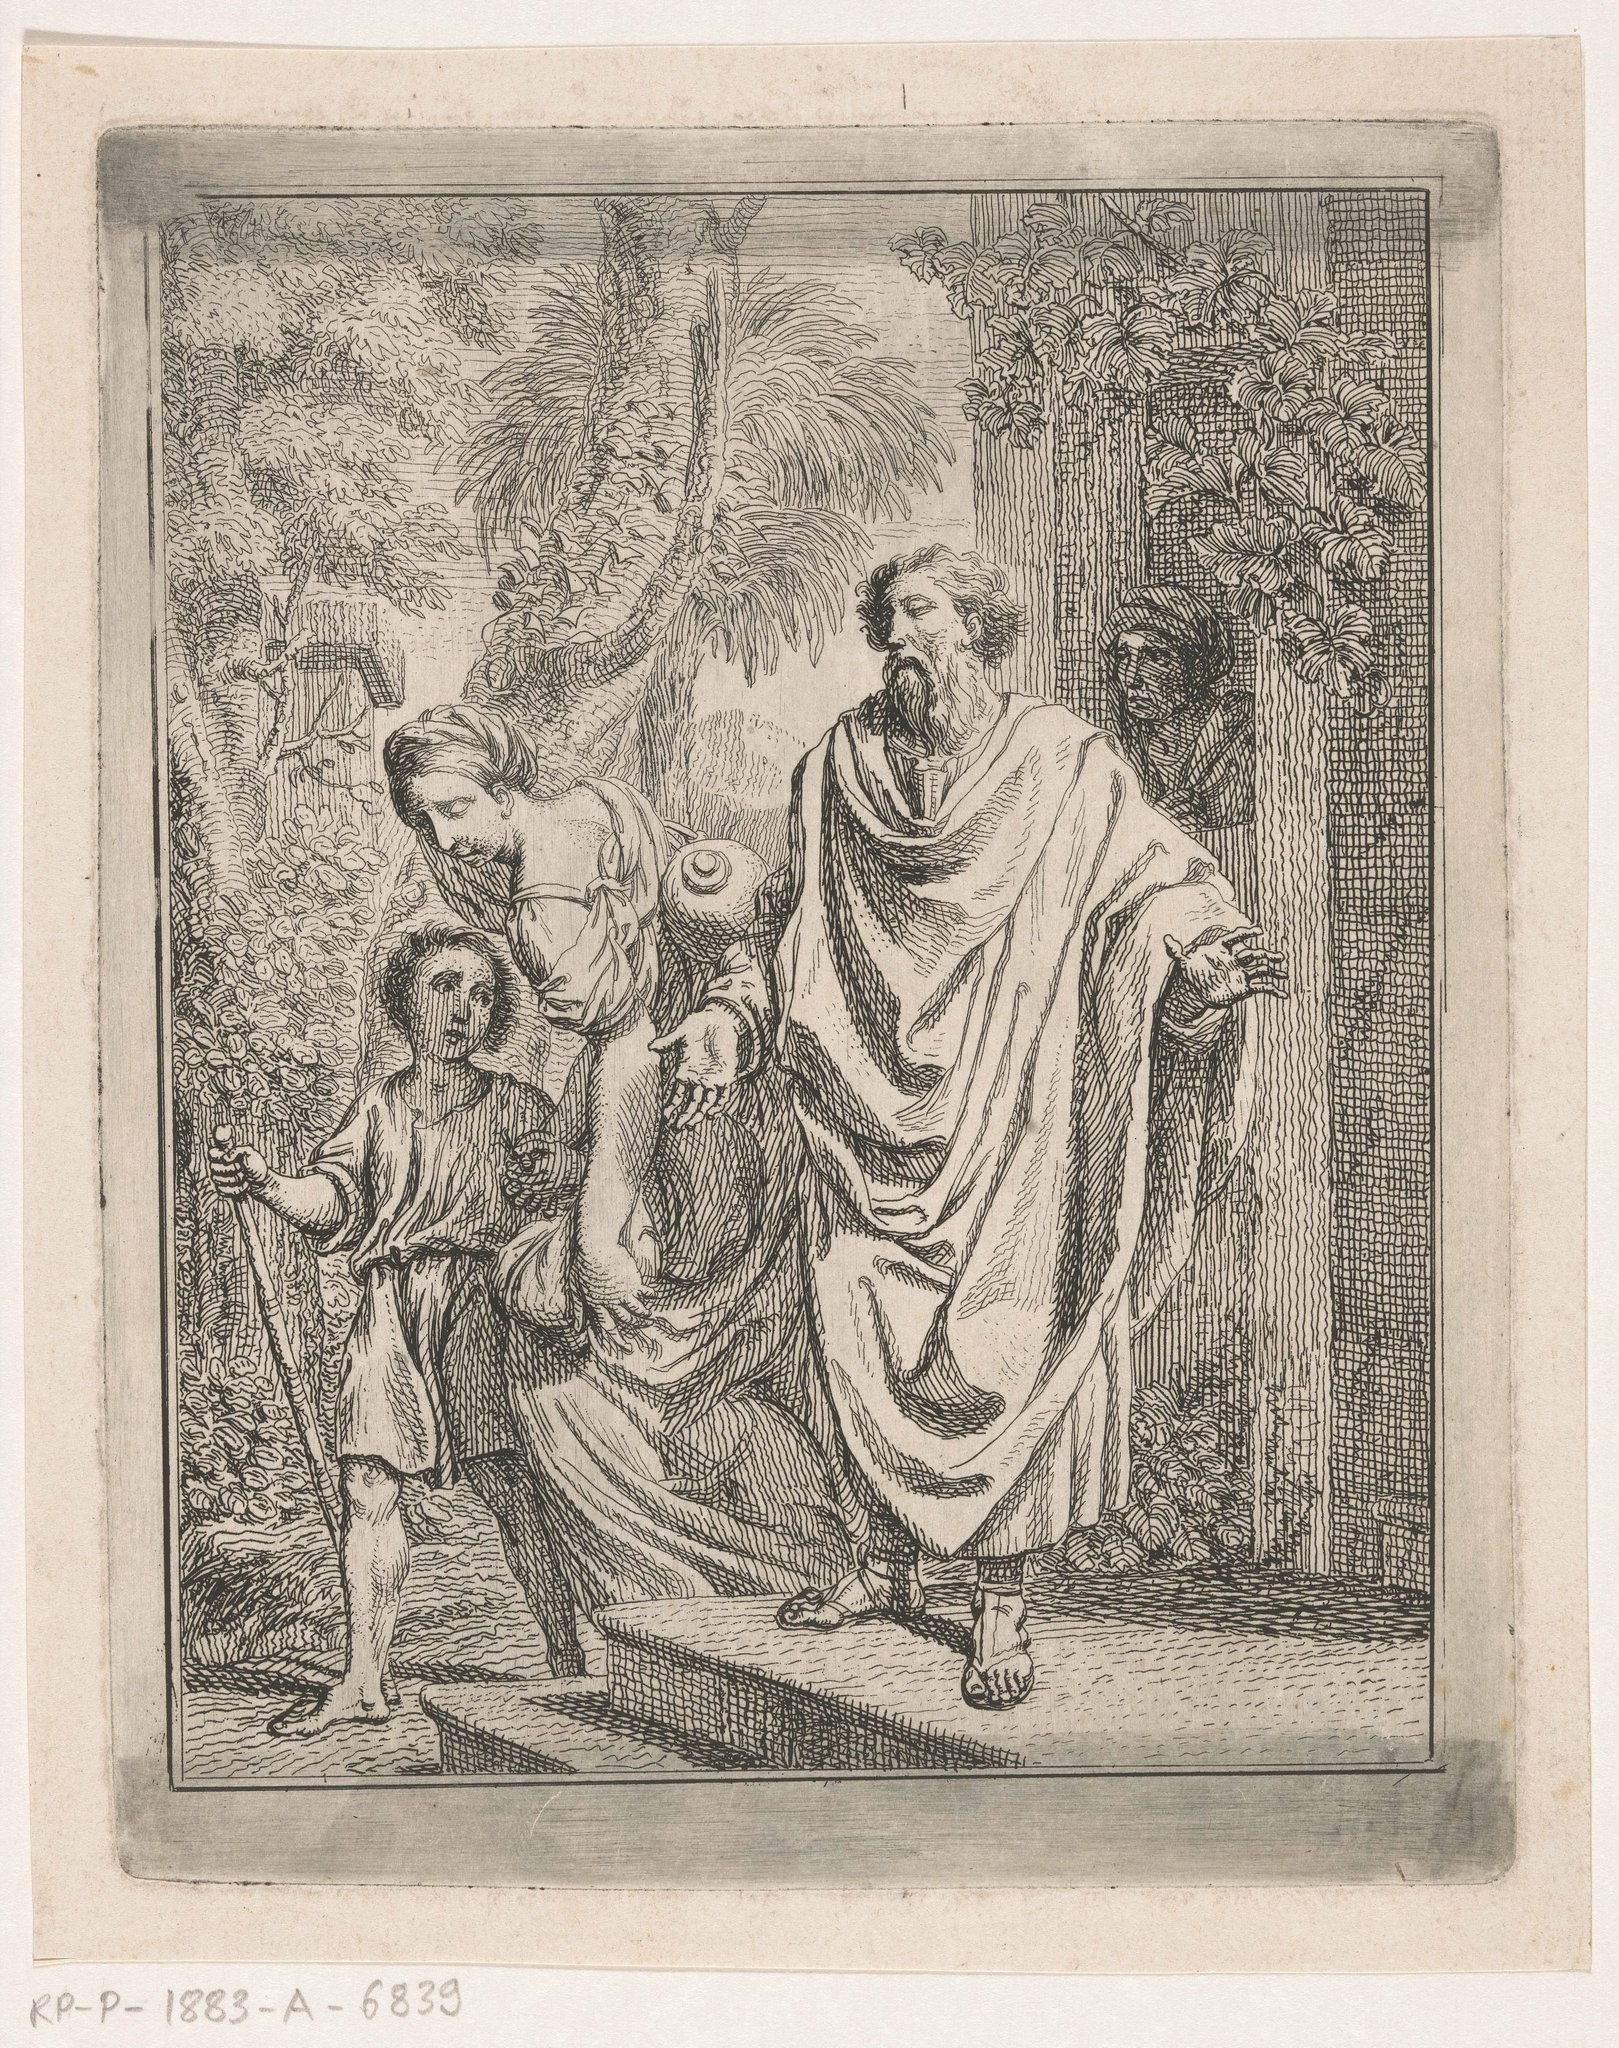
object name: print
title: Abraham verdrijft Hagar en Ismaël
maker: louis fabritius dubourg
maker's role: draughtsman, print maker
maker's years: 1693-1775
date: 1713-1775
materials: paper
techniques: etching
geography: amsterdam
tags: the banishment of hagar and ishmael (genesis 21:9-21)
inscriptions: collector's mark: Lugt 2228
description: Abraham staat in de deur van zijn huis en stuurt Hagar en Ismaël weg. Ismaël heeft een wandelstok, Hagar draagt een pak op haar rug. Achter Abraham staat Sara in de deuropening.